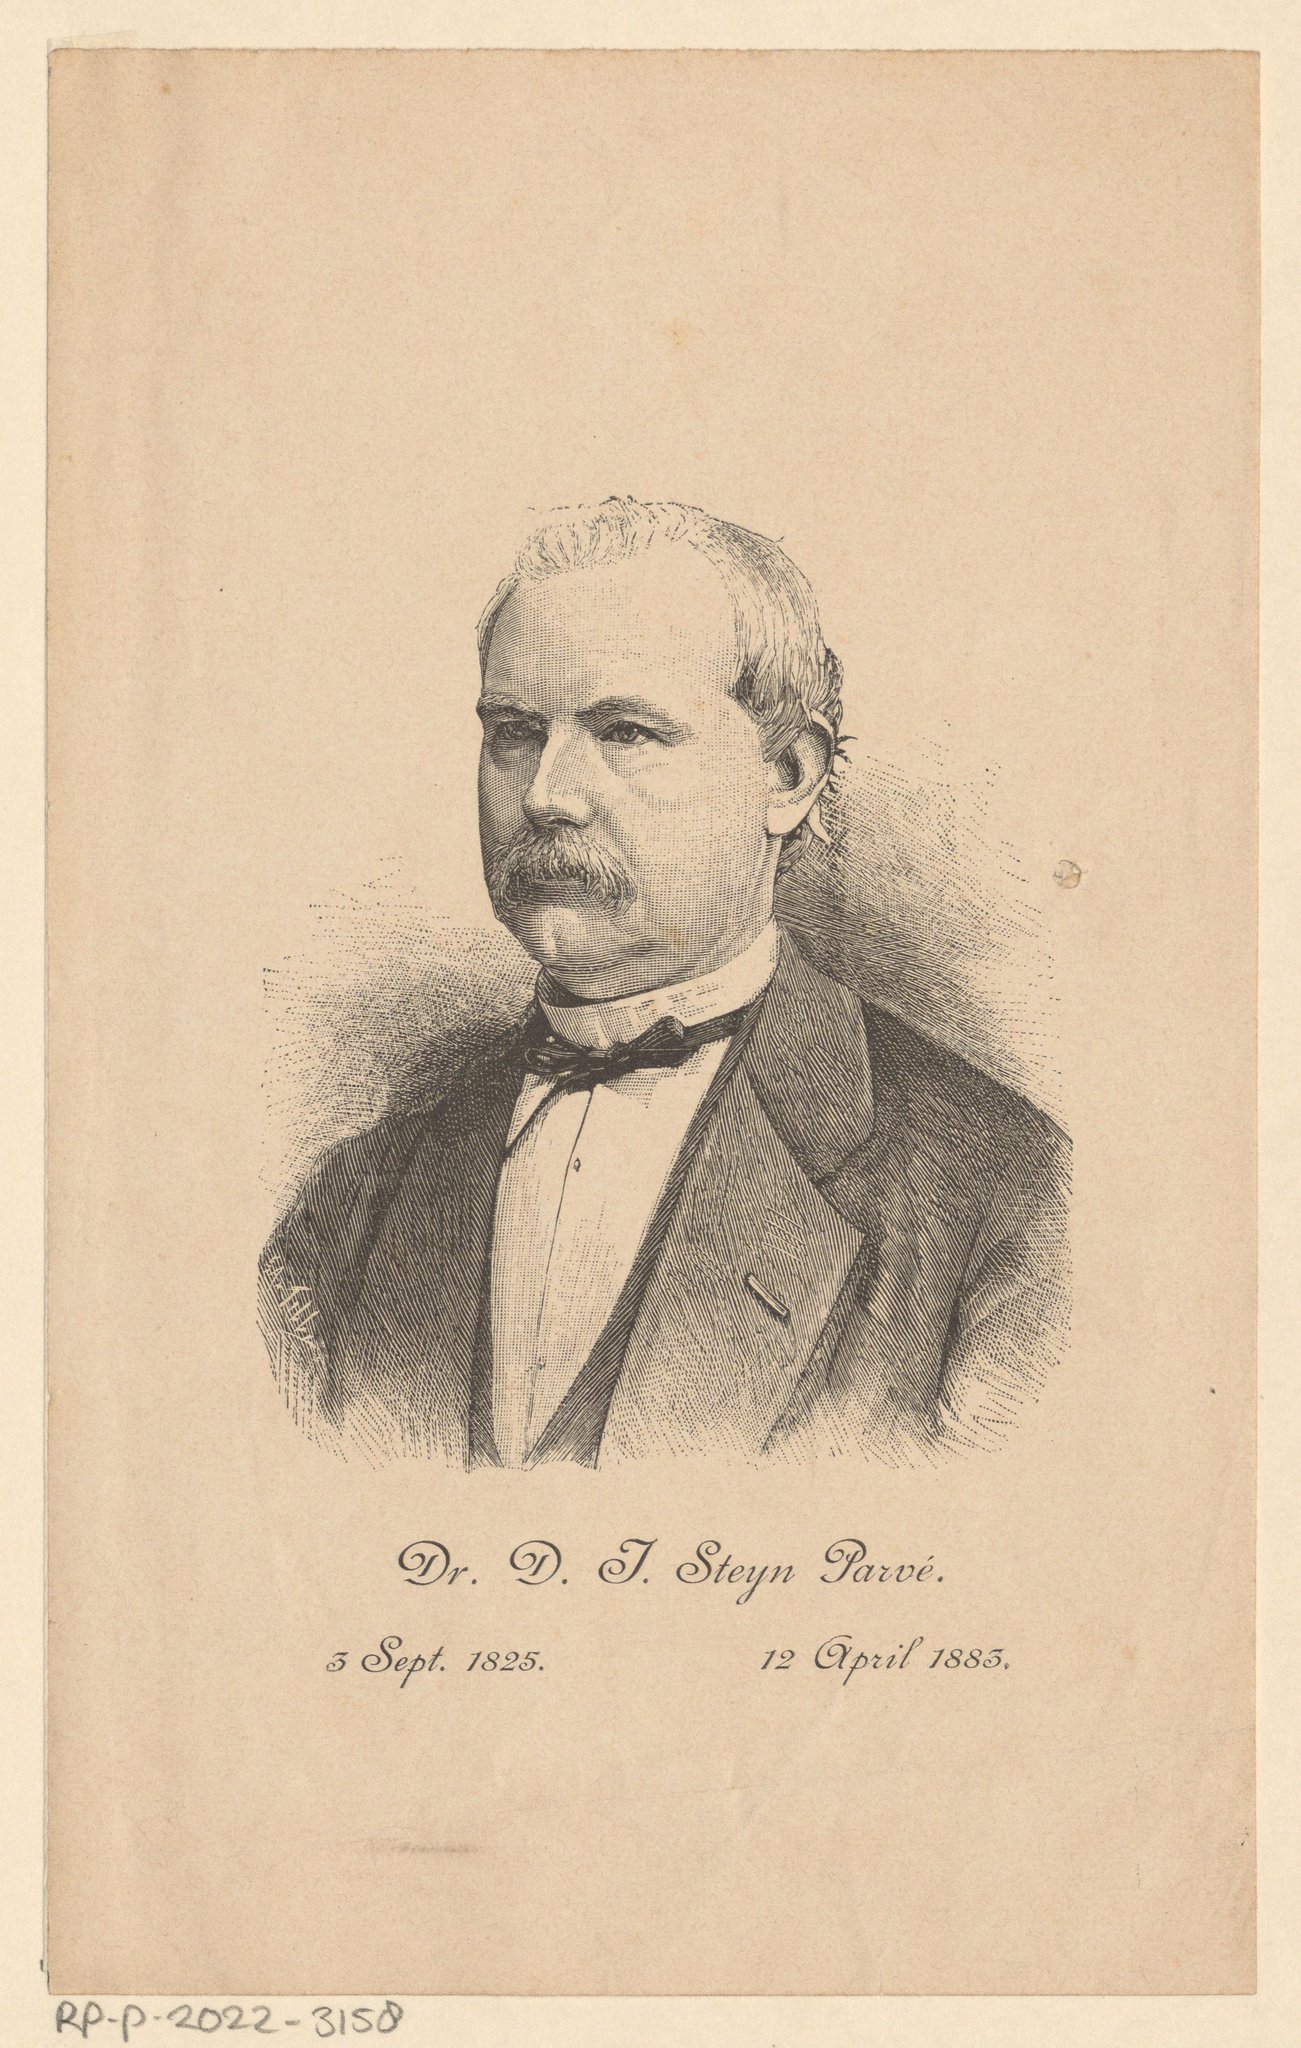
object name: print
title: Portret van Daniël Jan Steyn Parvé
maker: auguste tilly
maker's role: print maker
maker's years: 1840-1898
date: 1883-1898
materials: paper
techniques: engraving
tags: historical persons, magistracy, judges